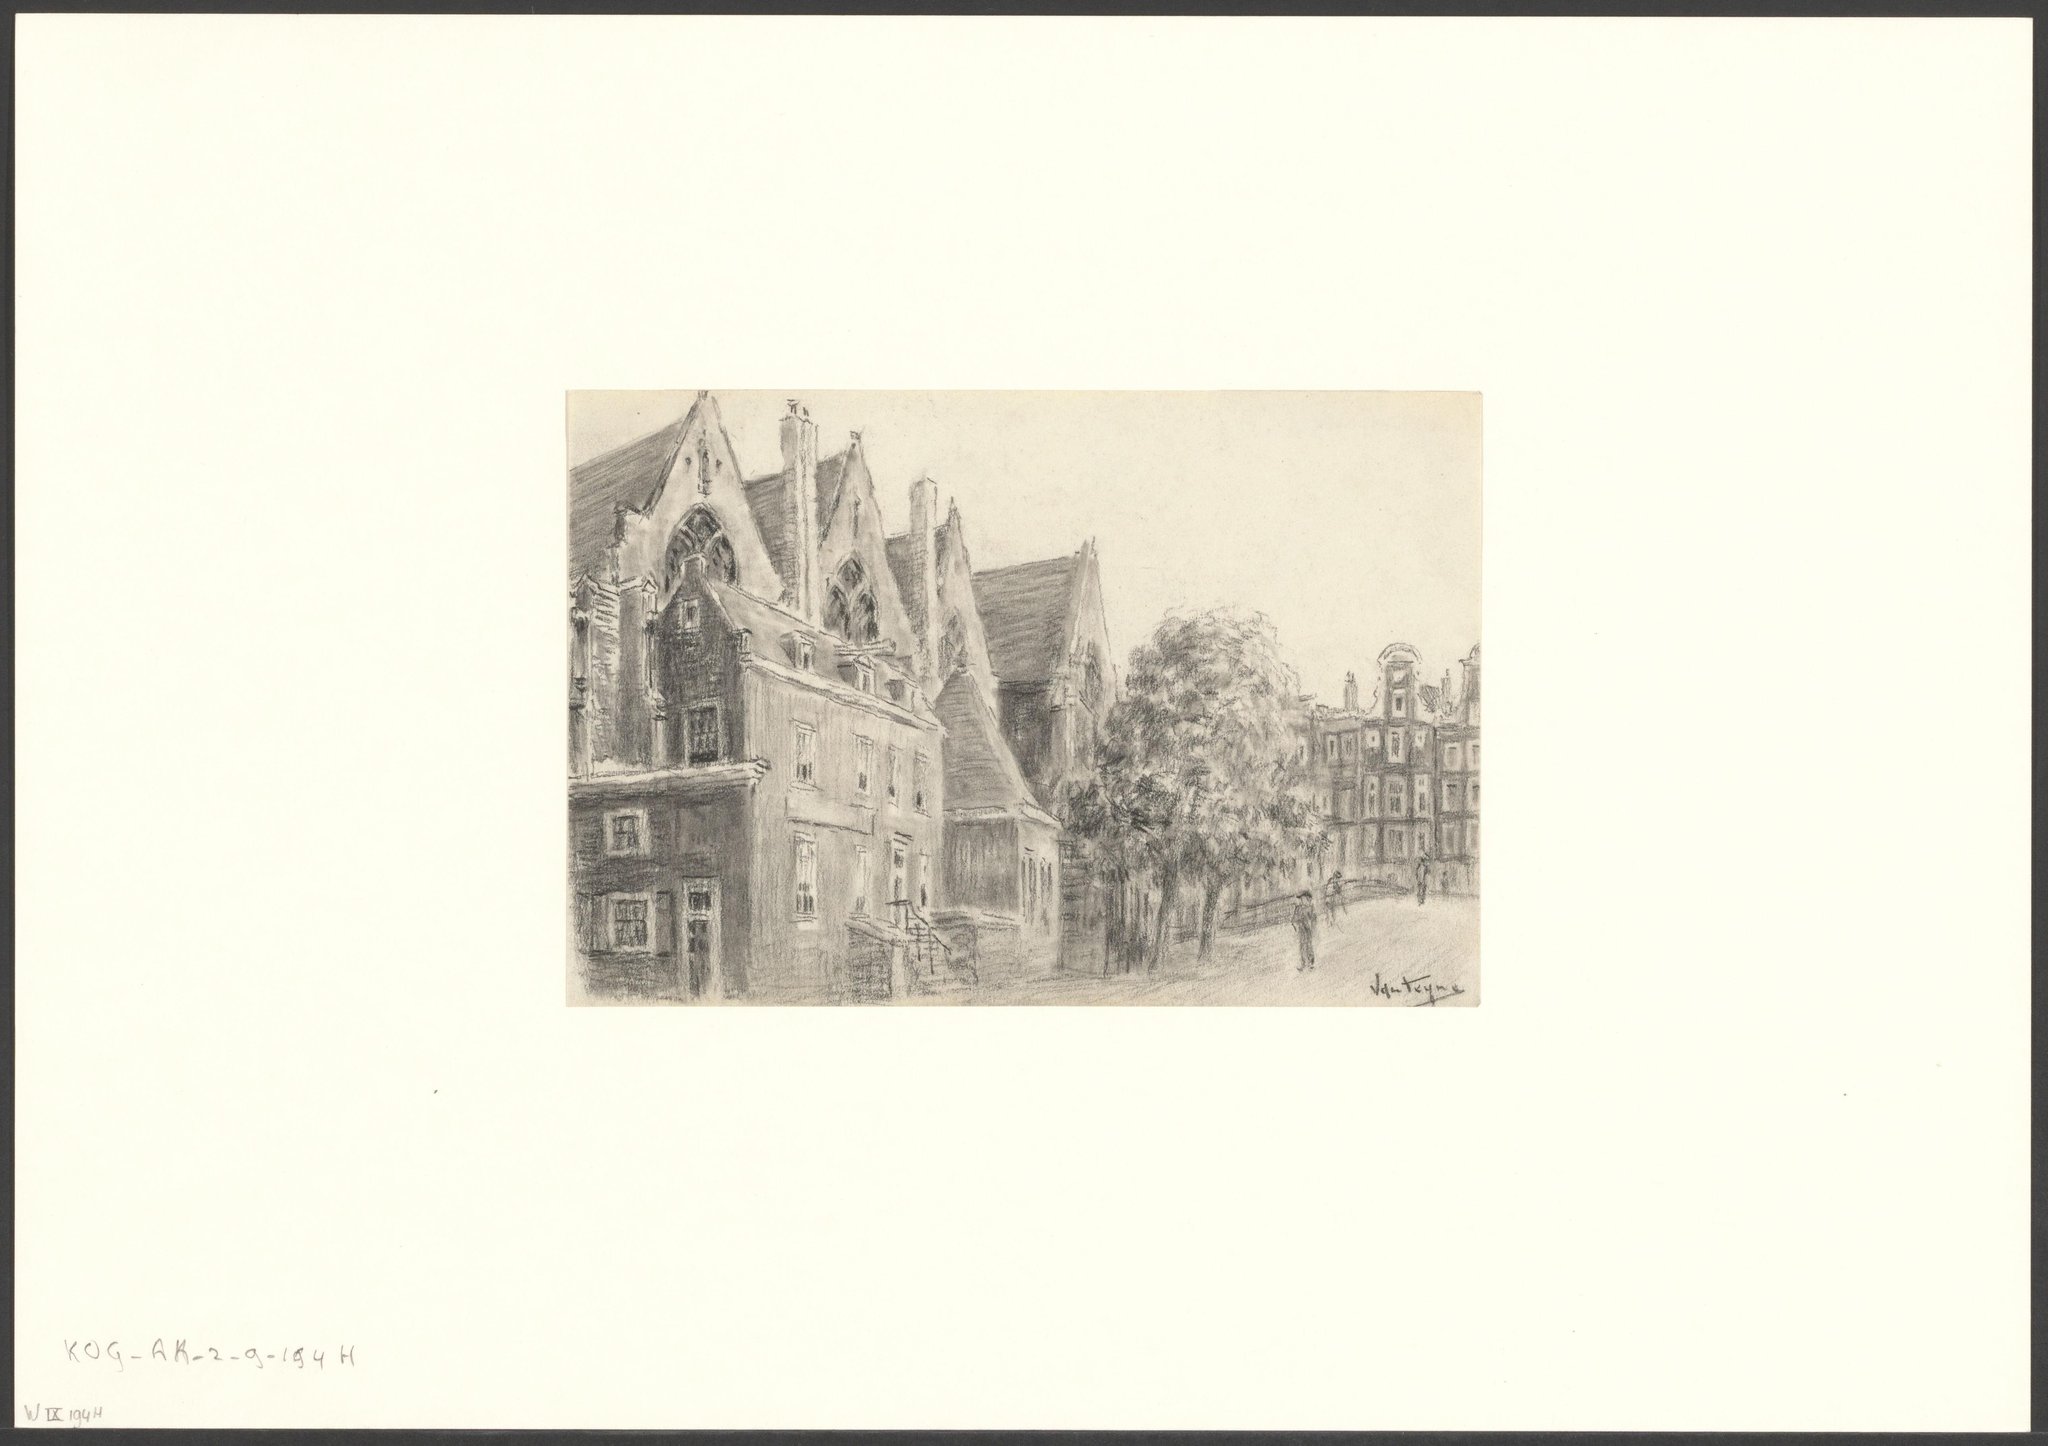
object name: drawing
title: Gezicht op de Oude Kerk en het Oudekerksplein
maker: anthonie van teijn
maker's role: draughtsman, painter, print maker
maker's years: 1863-1943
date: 1906-1927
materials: chalk, paper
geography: amsterdam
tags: square, place, circus, etc., church (exterior)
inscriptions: signature: ‘Van Teyne’, inscription: ‘Oude Kerk met het oude kerksplein / zuid-zijde. geteekend Juni 1927. / [...]’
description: Tekening binnen de Atlas Van Eck ingedeeld op wijknummer 9.